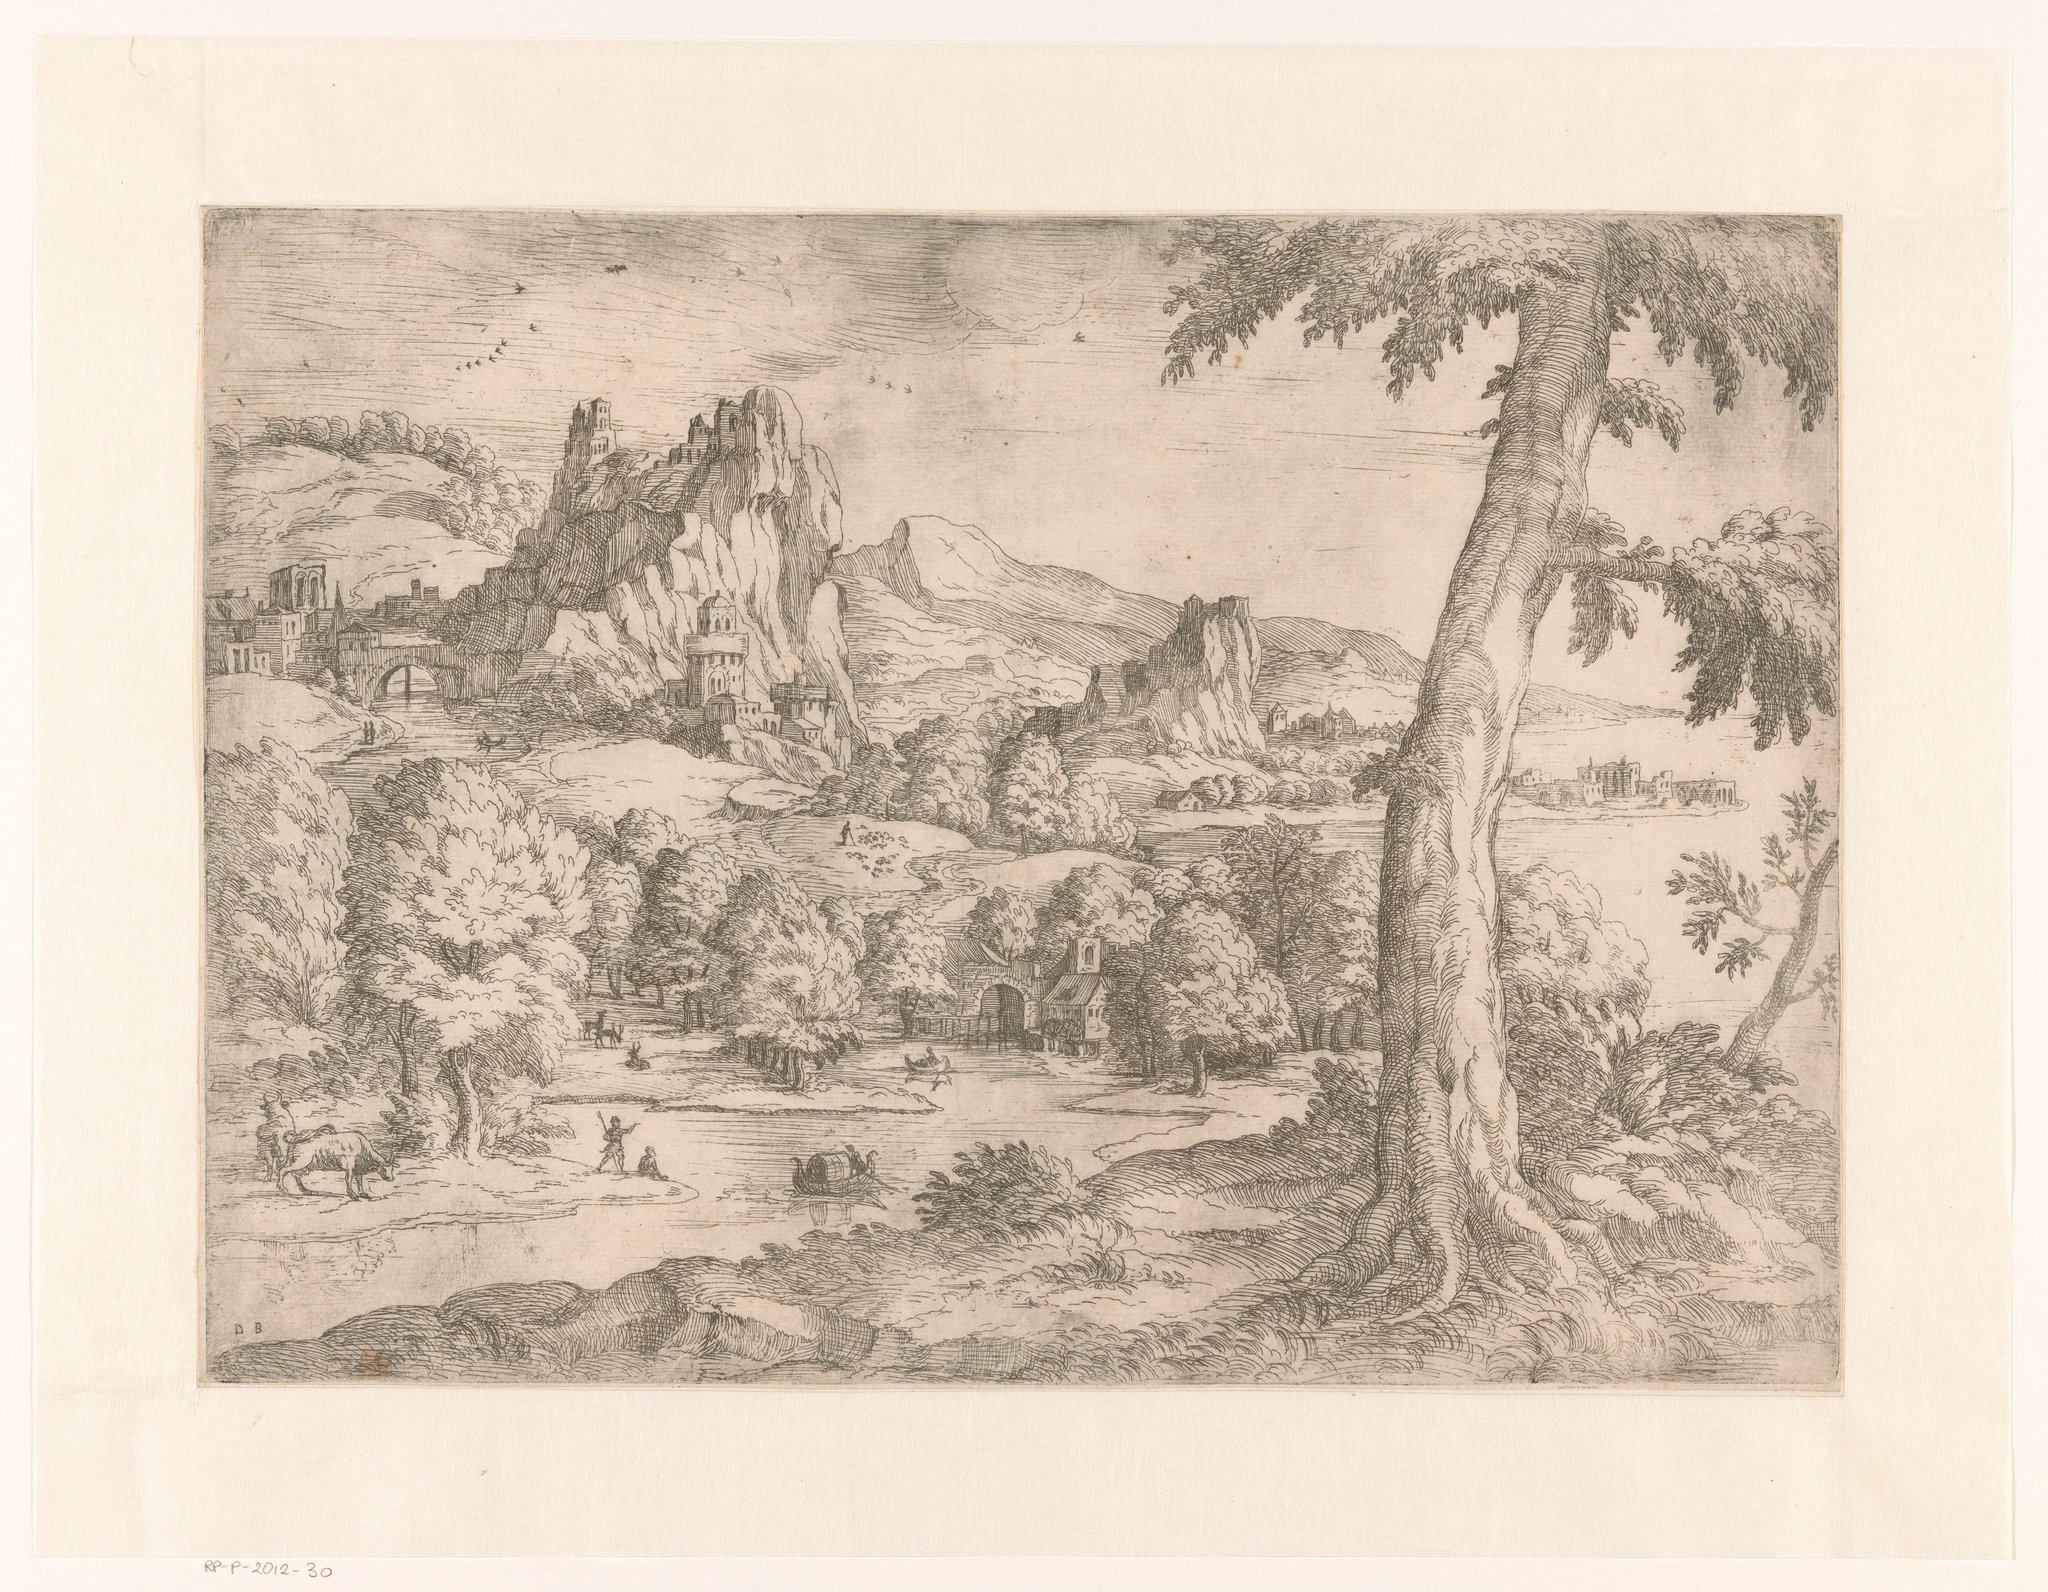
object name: print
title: Panoramisch landschap met grote boom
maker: monogrammist db (etser 16de eeuw)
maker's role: print maker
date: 1560-1580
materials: paper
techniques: etching, intaglio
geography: italy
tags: landscapes in the temperate zone - hh - ideal landscapes, river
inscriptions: collector's mark: Lugt 2760, collector's mark: Lugt 2228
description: Panoramisch landschap met een grote boom op de voorgrond rechts. Op het middenplan een rivier met gondel en runderen en herten tussen de struiken. Op de achtergrond een kustlandschap met bergen en een stad.